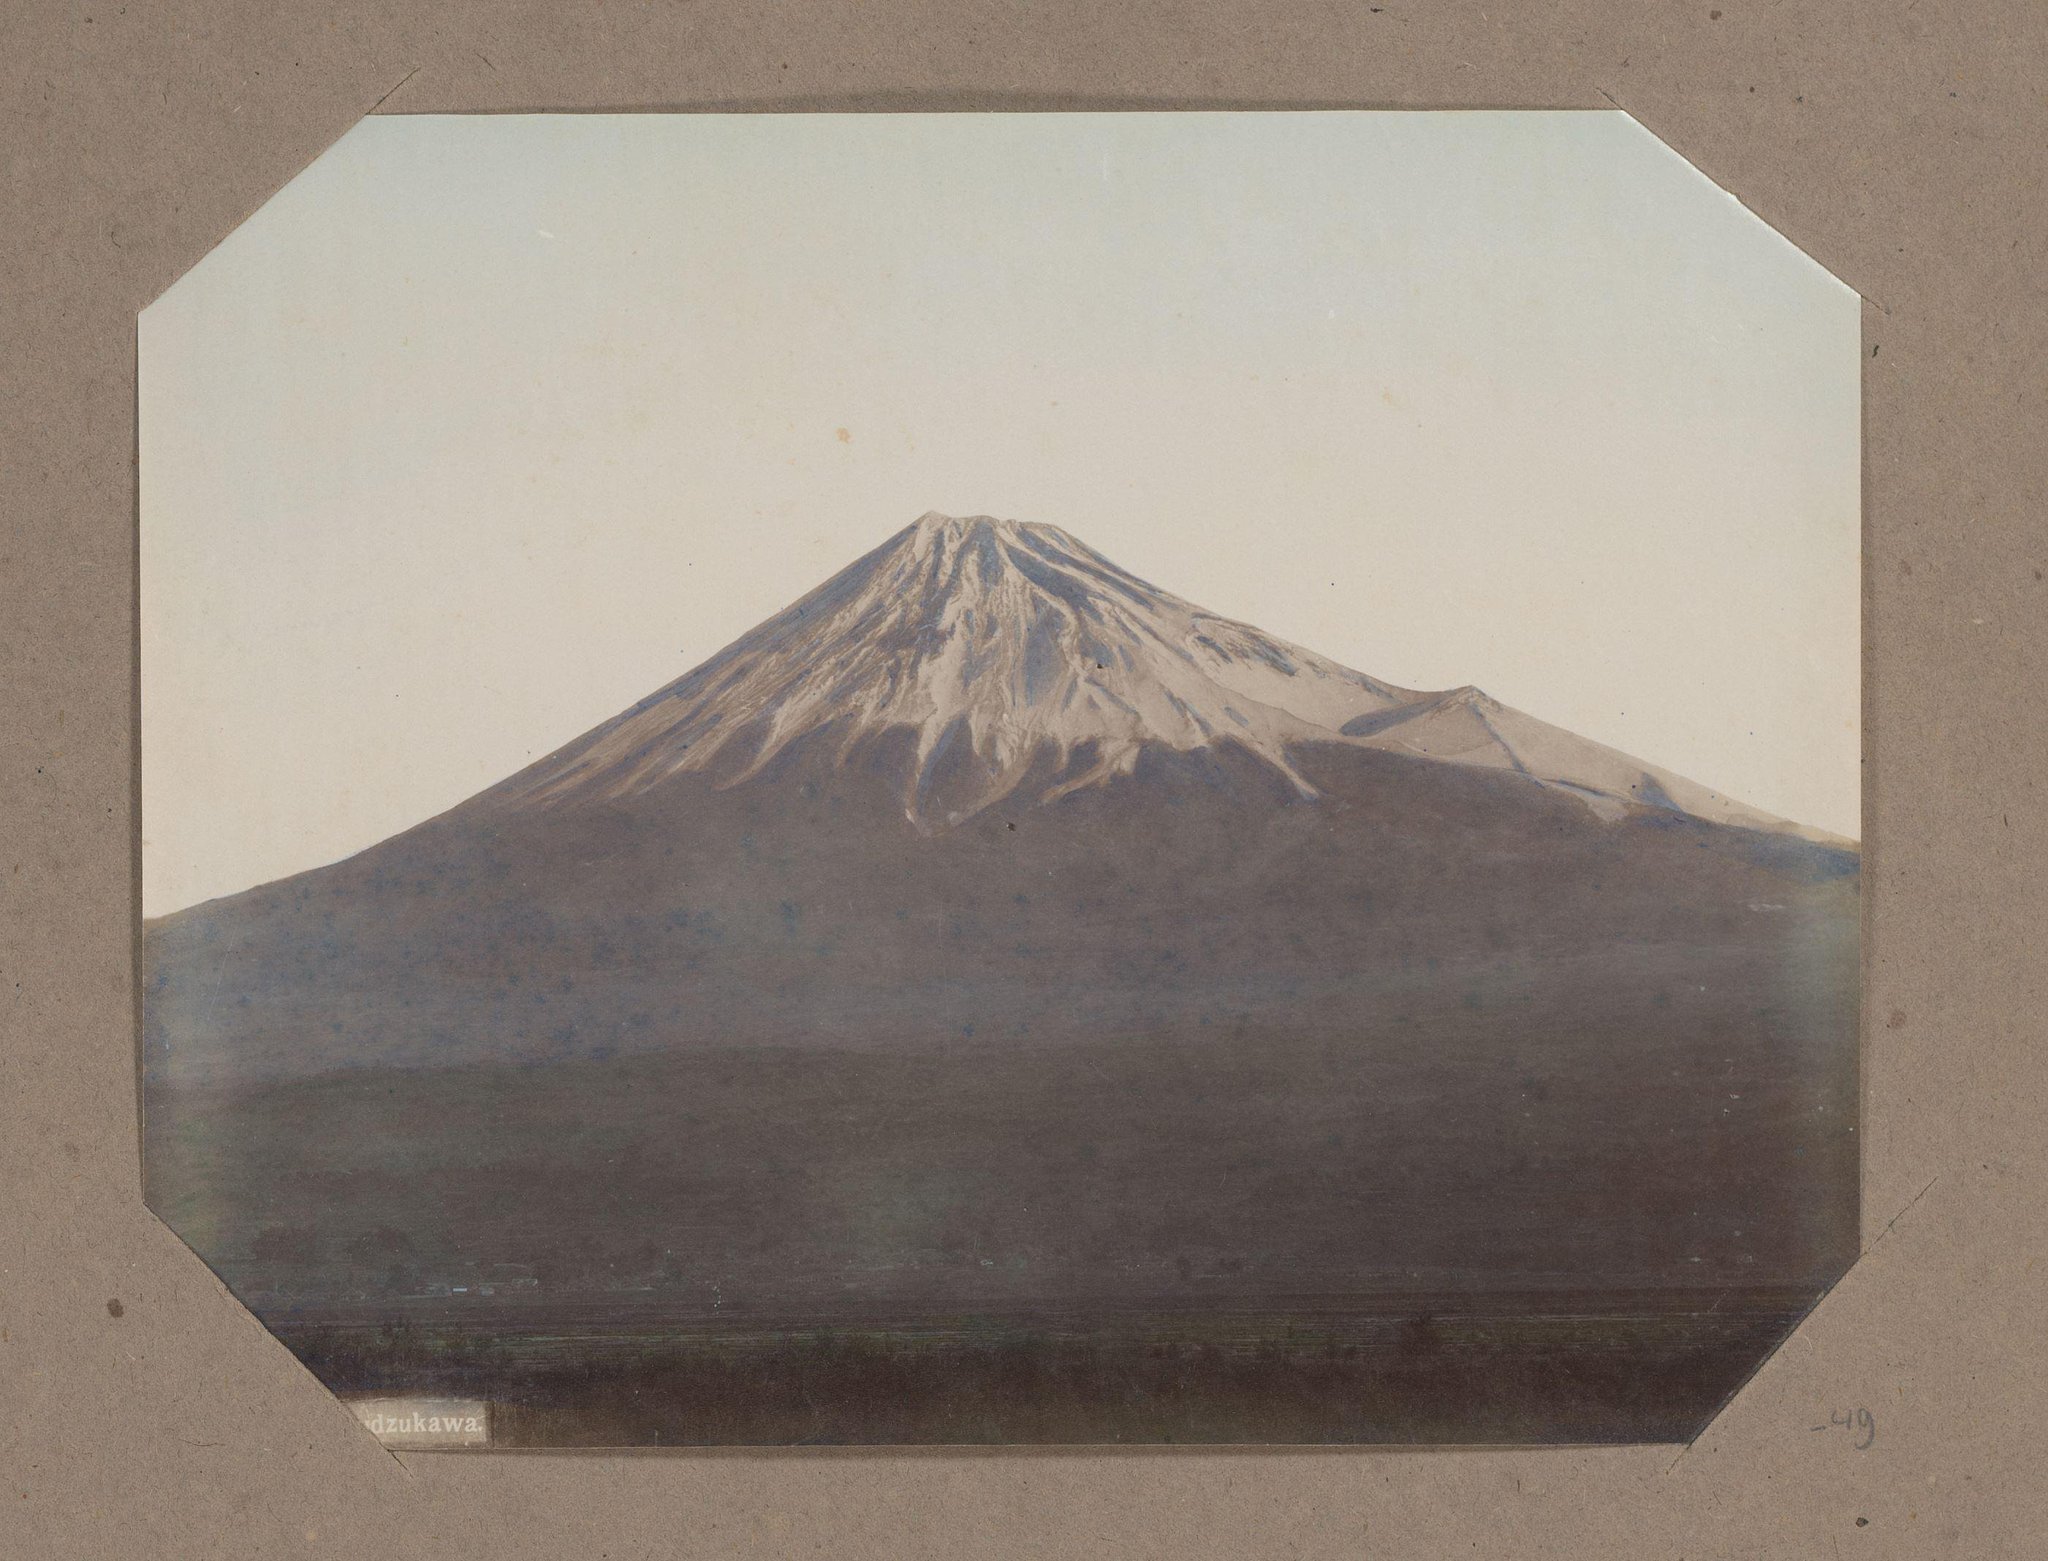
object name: photograph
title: Gezicht op de berg Fuji vanaf Sudzukawa, Japan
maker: Anonymous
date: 1890-1903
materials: paper, photographic support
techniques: albumen print, hand coloring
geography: japan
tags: mountains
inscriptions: inscription: ‘1100 Fuji from Sudzukawa’